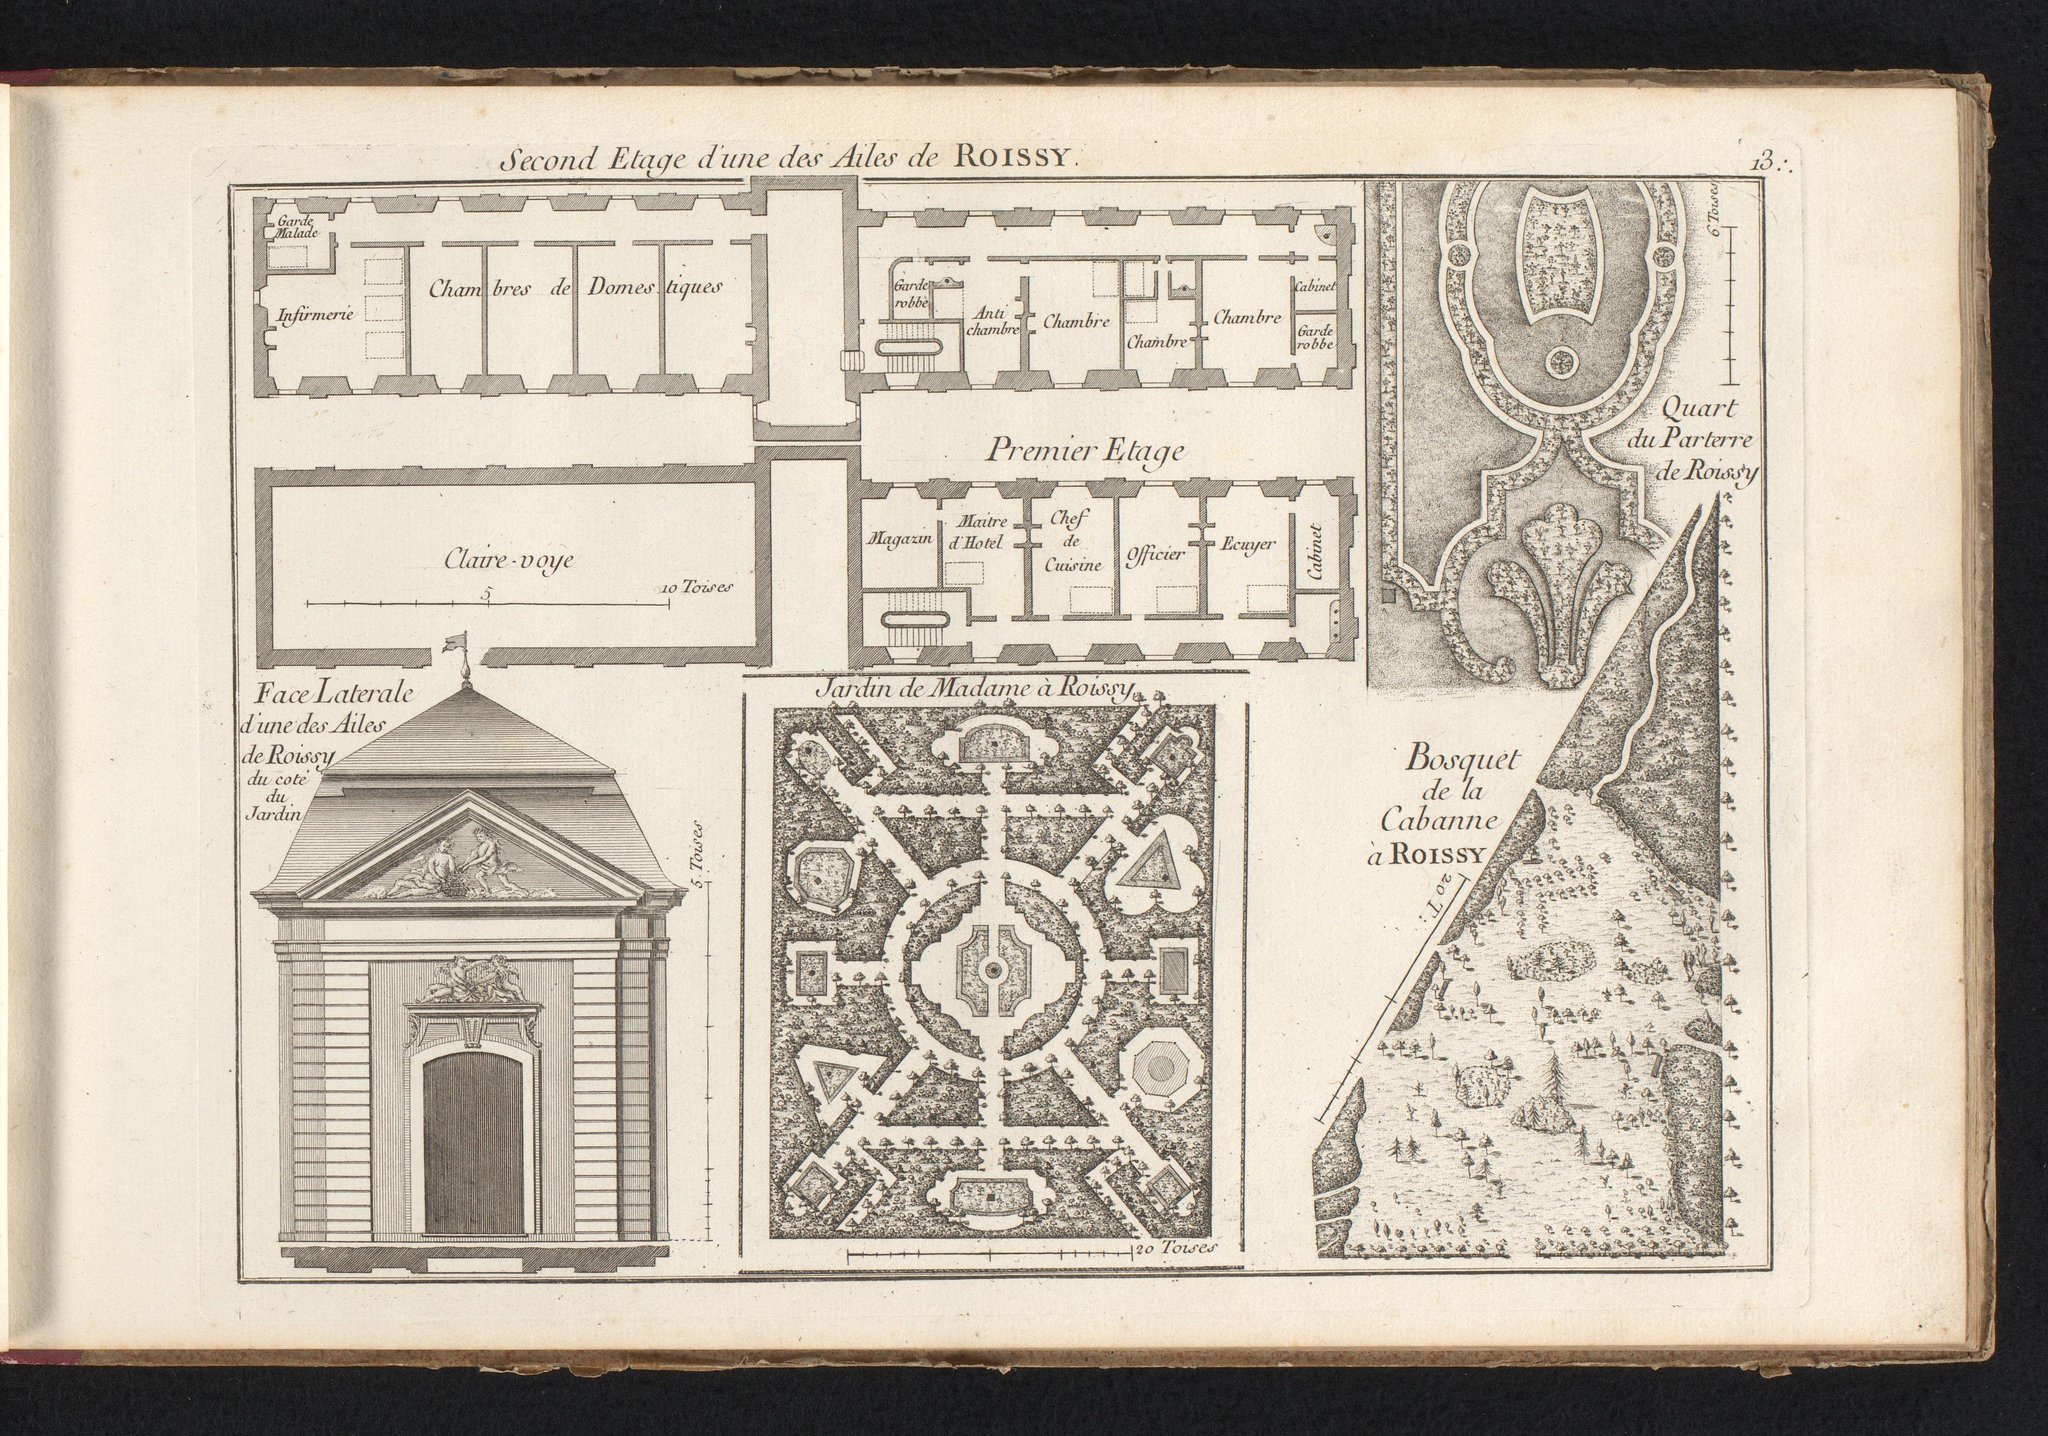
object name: album leaf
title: Landschapstuinen in Chinees-Engelse stijl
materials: paper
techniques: engraving, etching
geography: paris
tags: plan, map of garden, castle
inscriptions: collector's mark: Lugt 2760, collector's mark: Lugt 2228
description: De serie 'Jardins anglo-chinois à la mode' verscheen in totaal in 21 zogeheten 'cahiers' (afleveringen). De huidige prent komt uit het derde 'cahier'. Het Rijksmuseum Amsterdam bezit drie banden met daarin in totaal zes 'cahiers' van deze reeks. In de documentatie wordt verwezen naar een in de bibliotheek van het Rijksmuseum Amsterdam aanwezige facsimile van het complete werk.